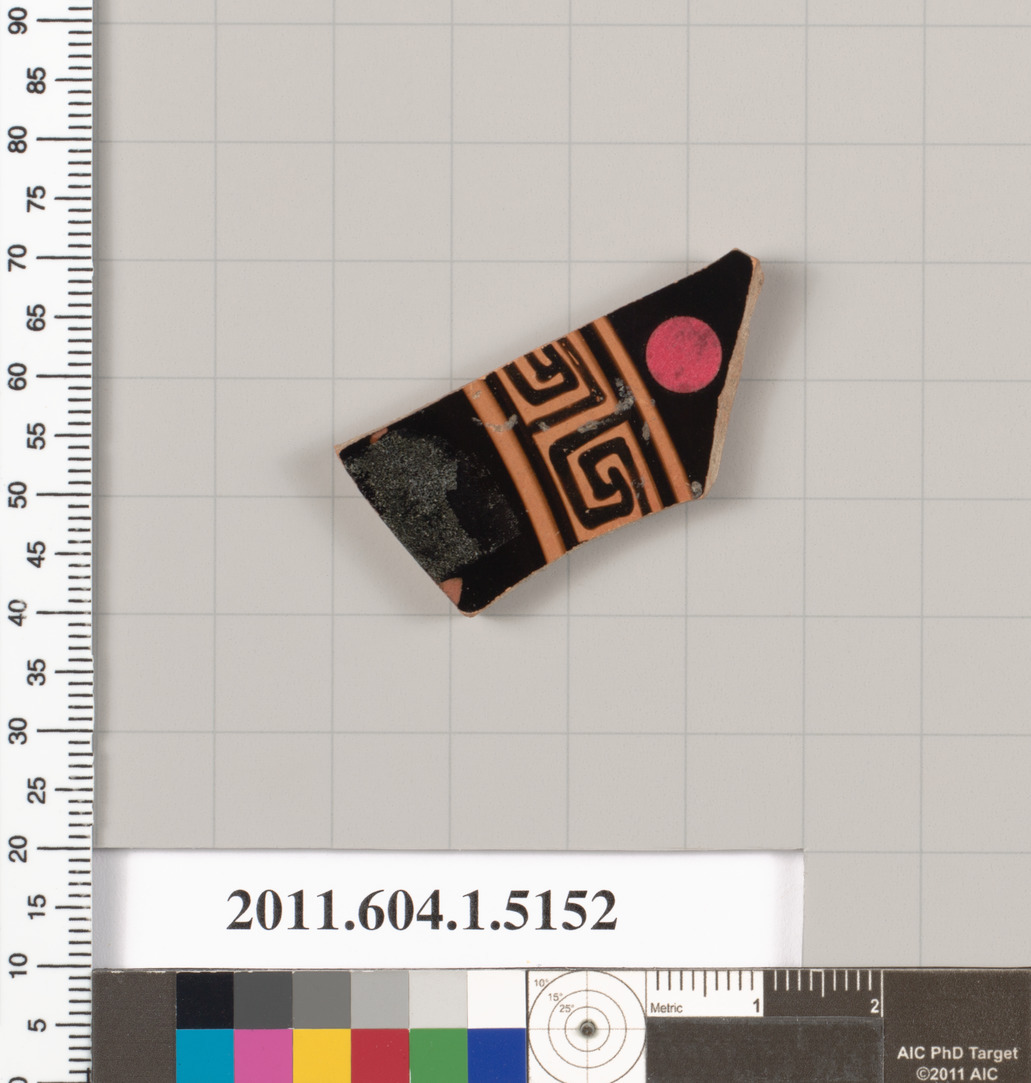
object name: kylix fragment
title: Terracotta fragment of a kylix (drinking cup)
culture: greek, attic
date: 520-500 BCE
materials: terracotta